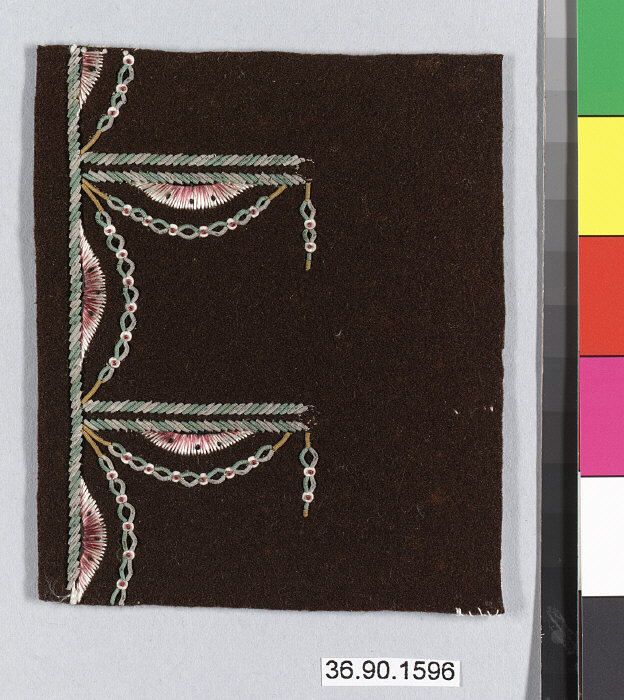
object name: sample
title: Embroidery sample for a man’s suit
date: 1785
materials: metal thread, silk, wool